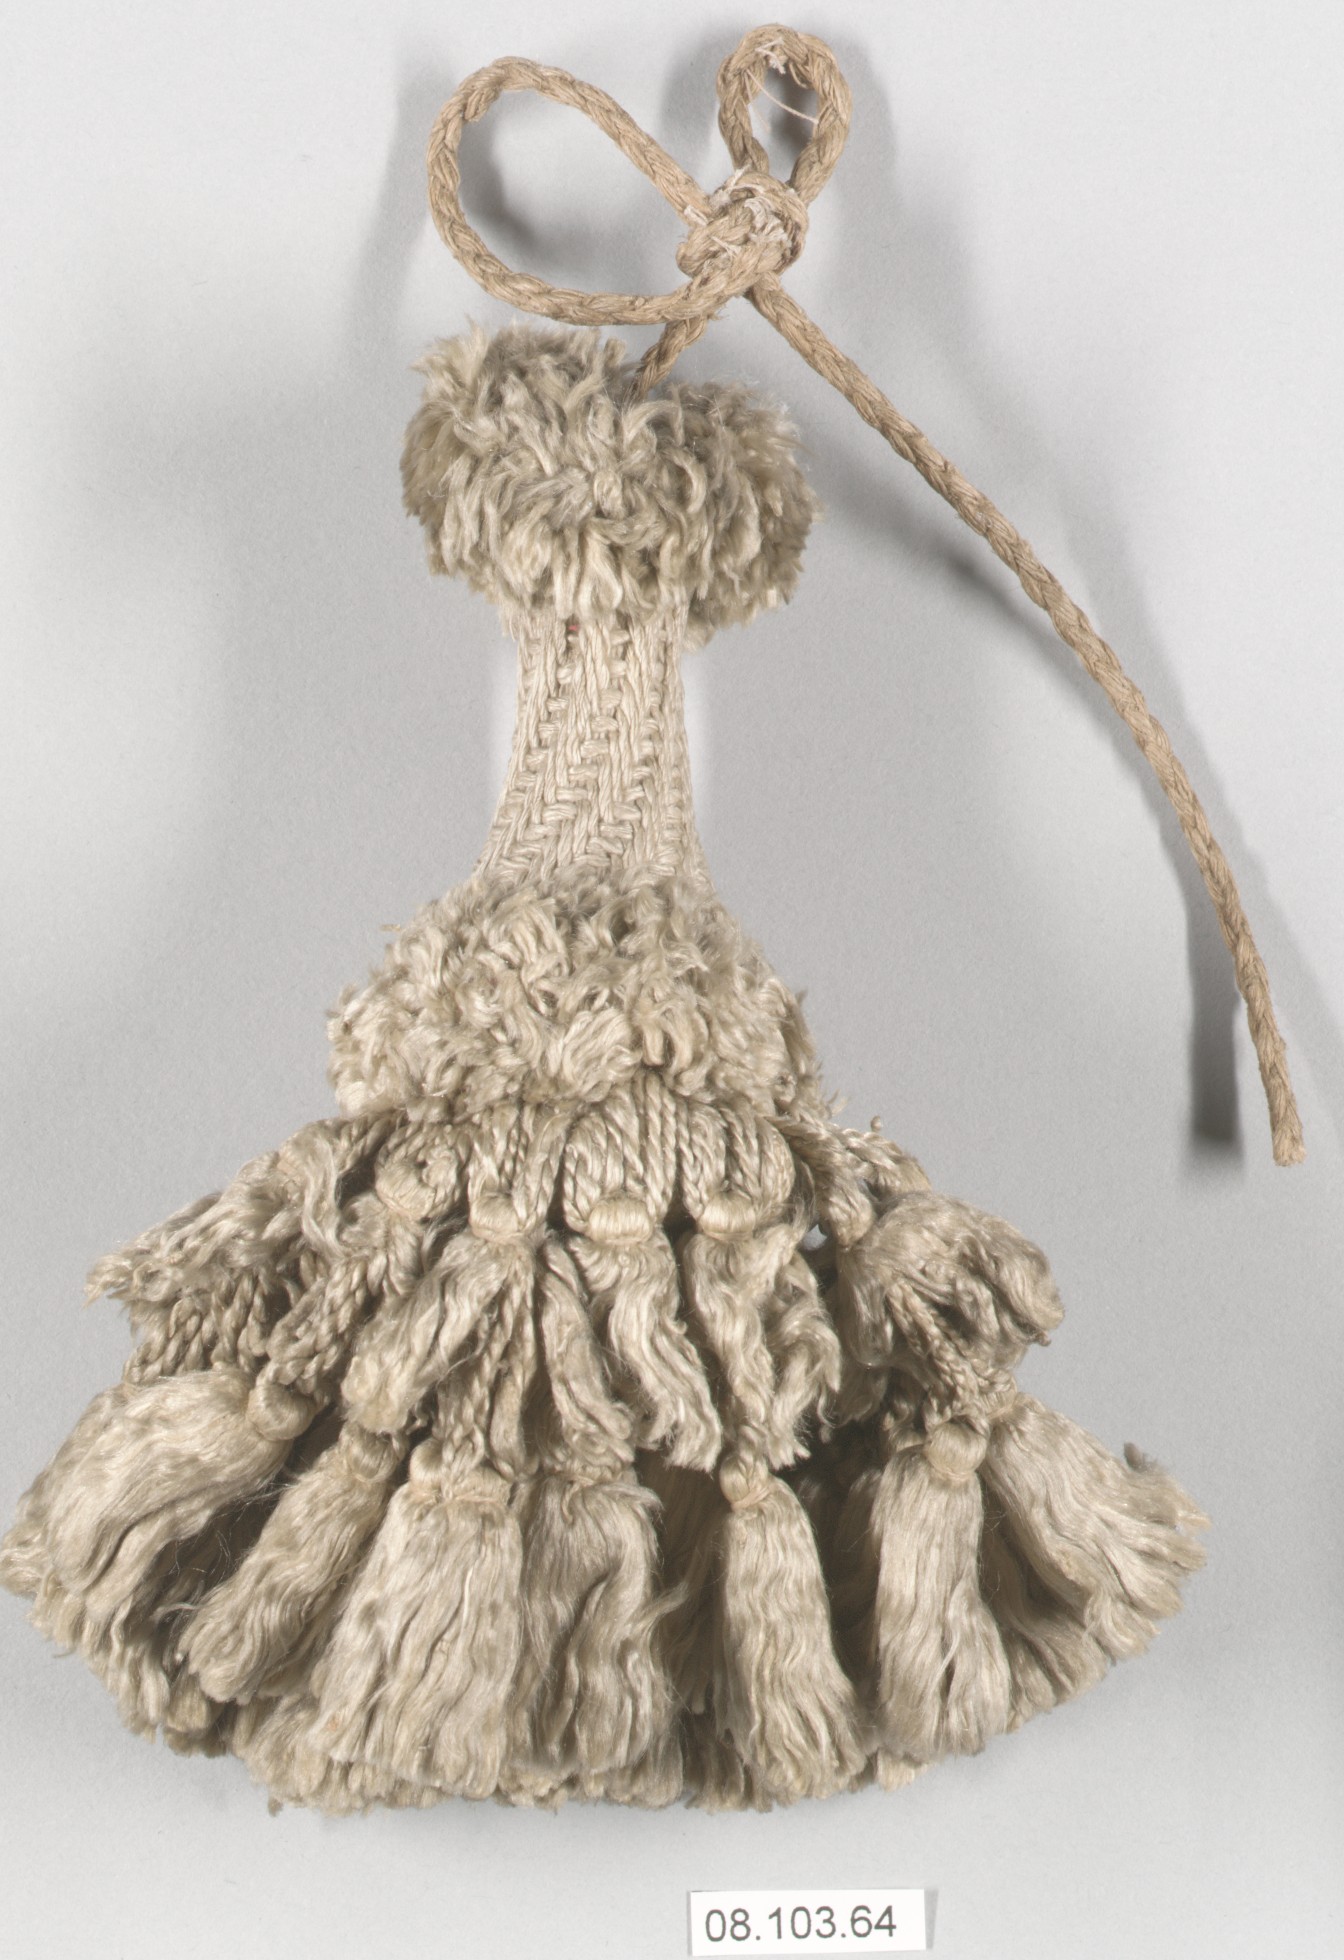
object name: tassel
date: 1501-1600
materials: silk